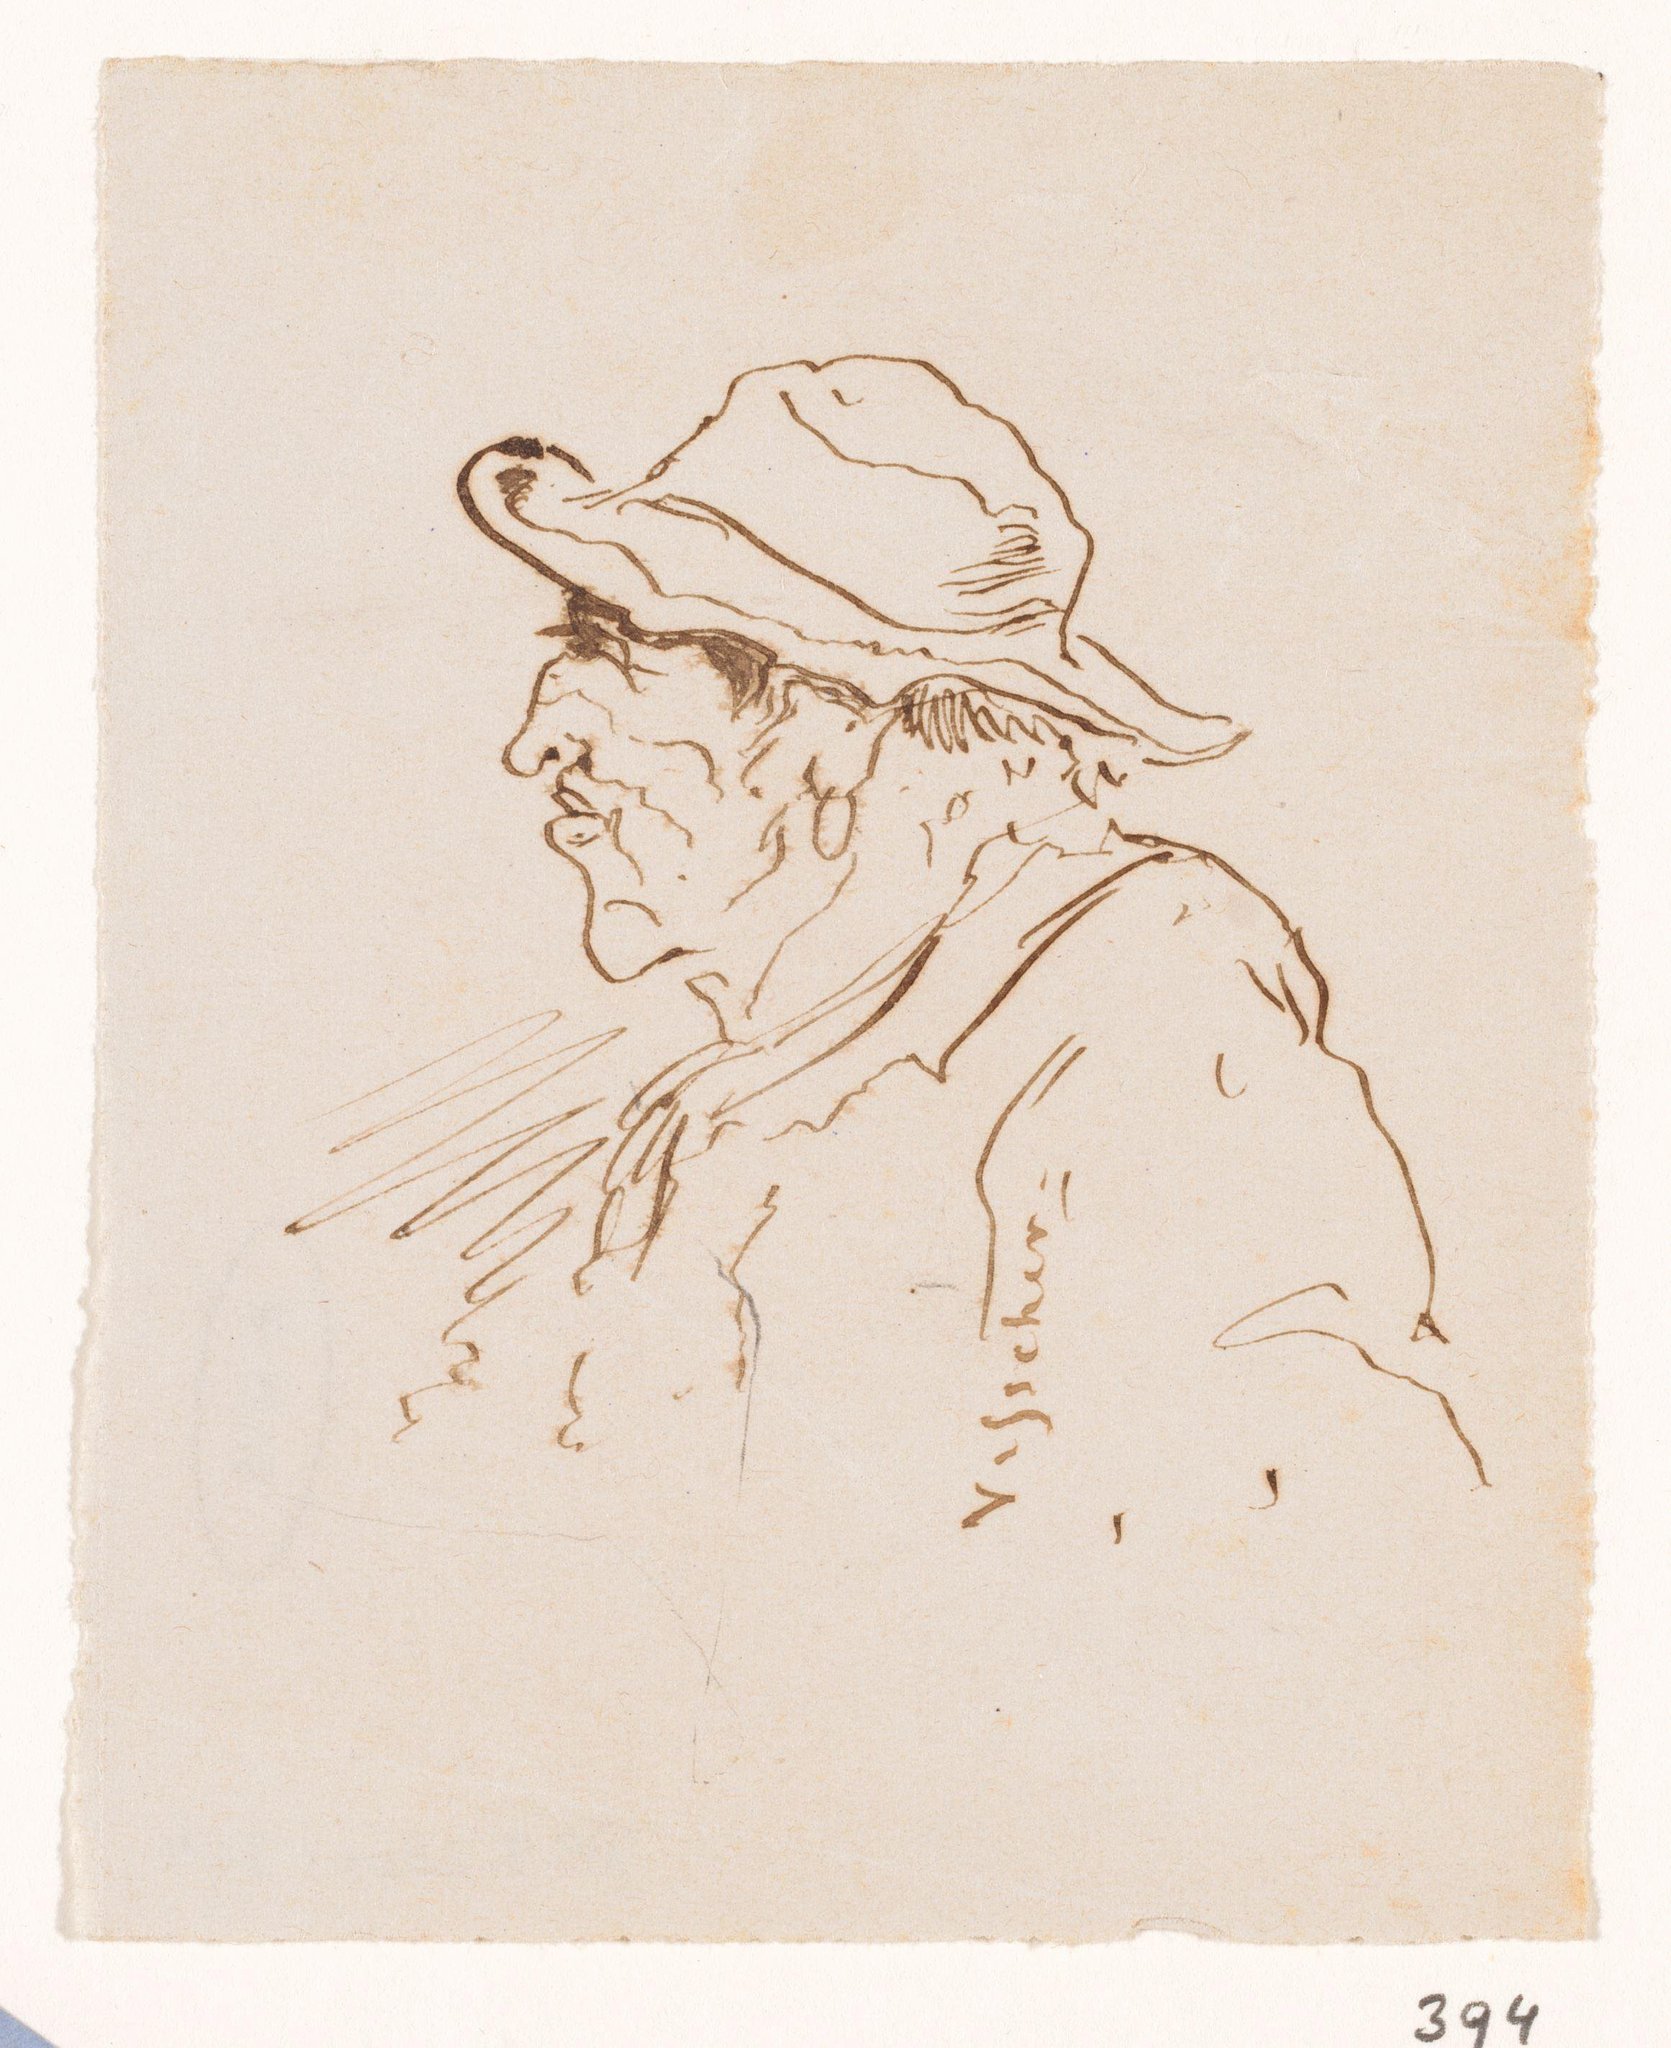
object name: drawing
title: Kop van een visser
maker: johannes tavenraat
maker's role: draughtsman, painter, print maker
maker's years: 1809-1881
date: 1840-1880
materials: ink, paper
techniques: pen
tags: caricatures (human types), commercial fishery (+ labourers ~ crafts, industries, agriculture)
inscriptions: annotation: ‘Visscher’, collector's mark: Lugt 2228